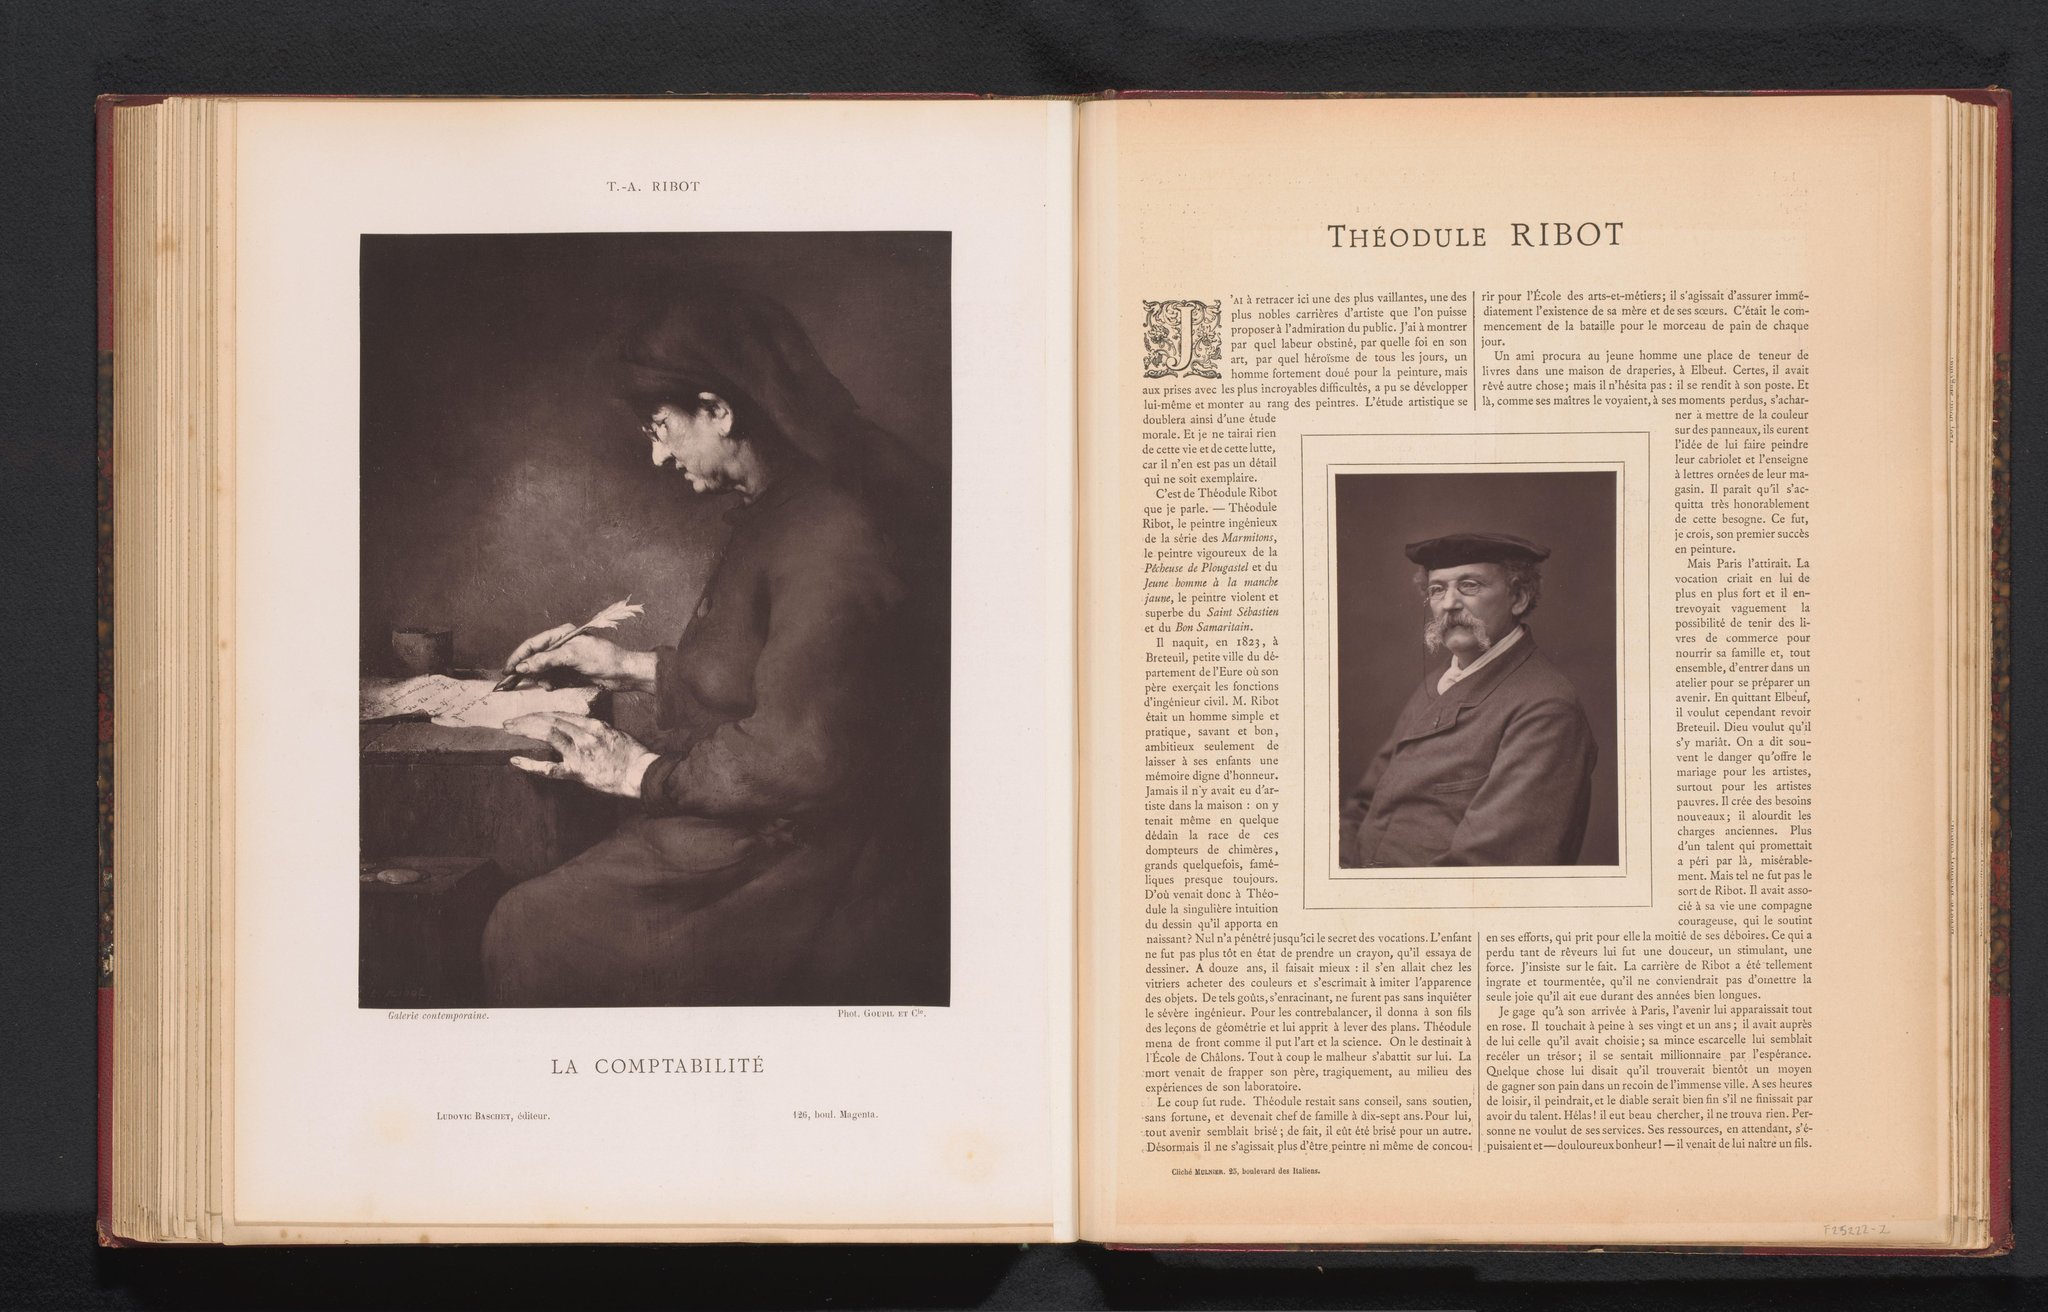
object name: photomechanical print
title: Reproductie van La Comptabilite door Théodule Augustin Ribot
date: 1874-1879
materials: paper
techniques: woodburytype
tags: handwriting, writing as activity, adult woman, painting, drawing and the graphic arts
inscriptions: inscription: ‘Galerie Contemporaine/ Ludovic Baschet, éditeur./ 126, boul. Magenta.’